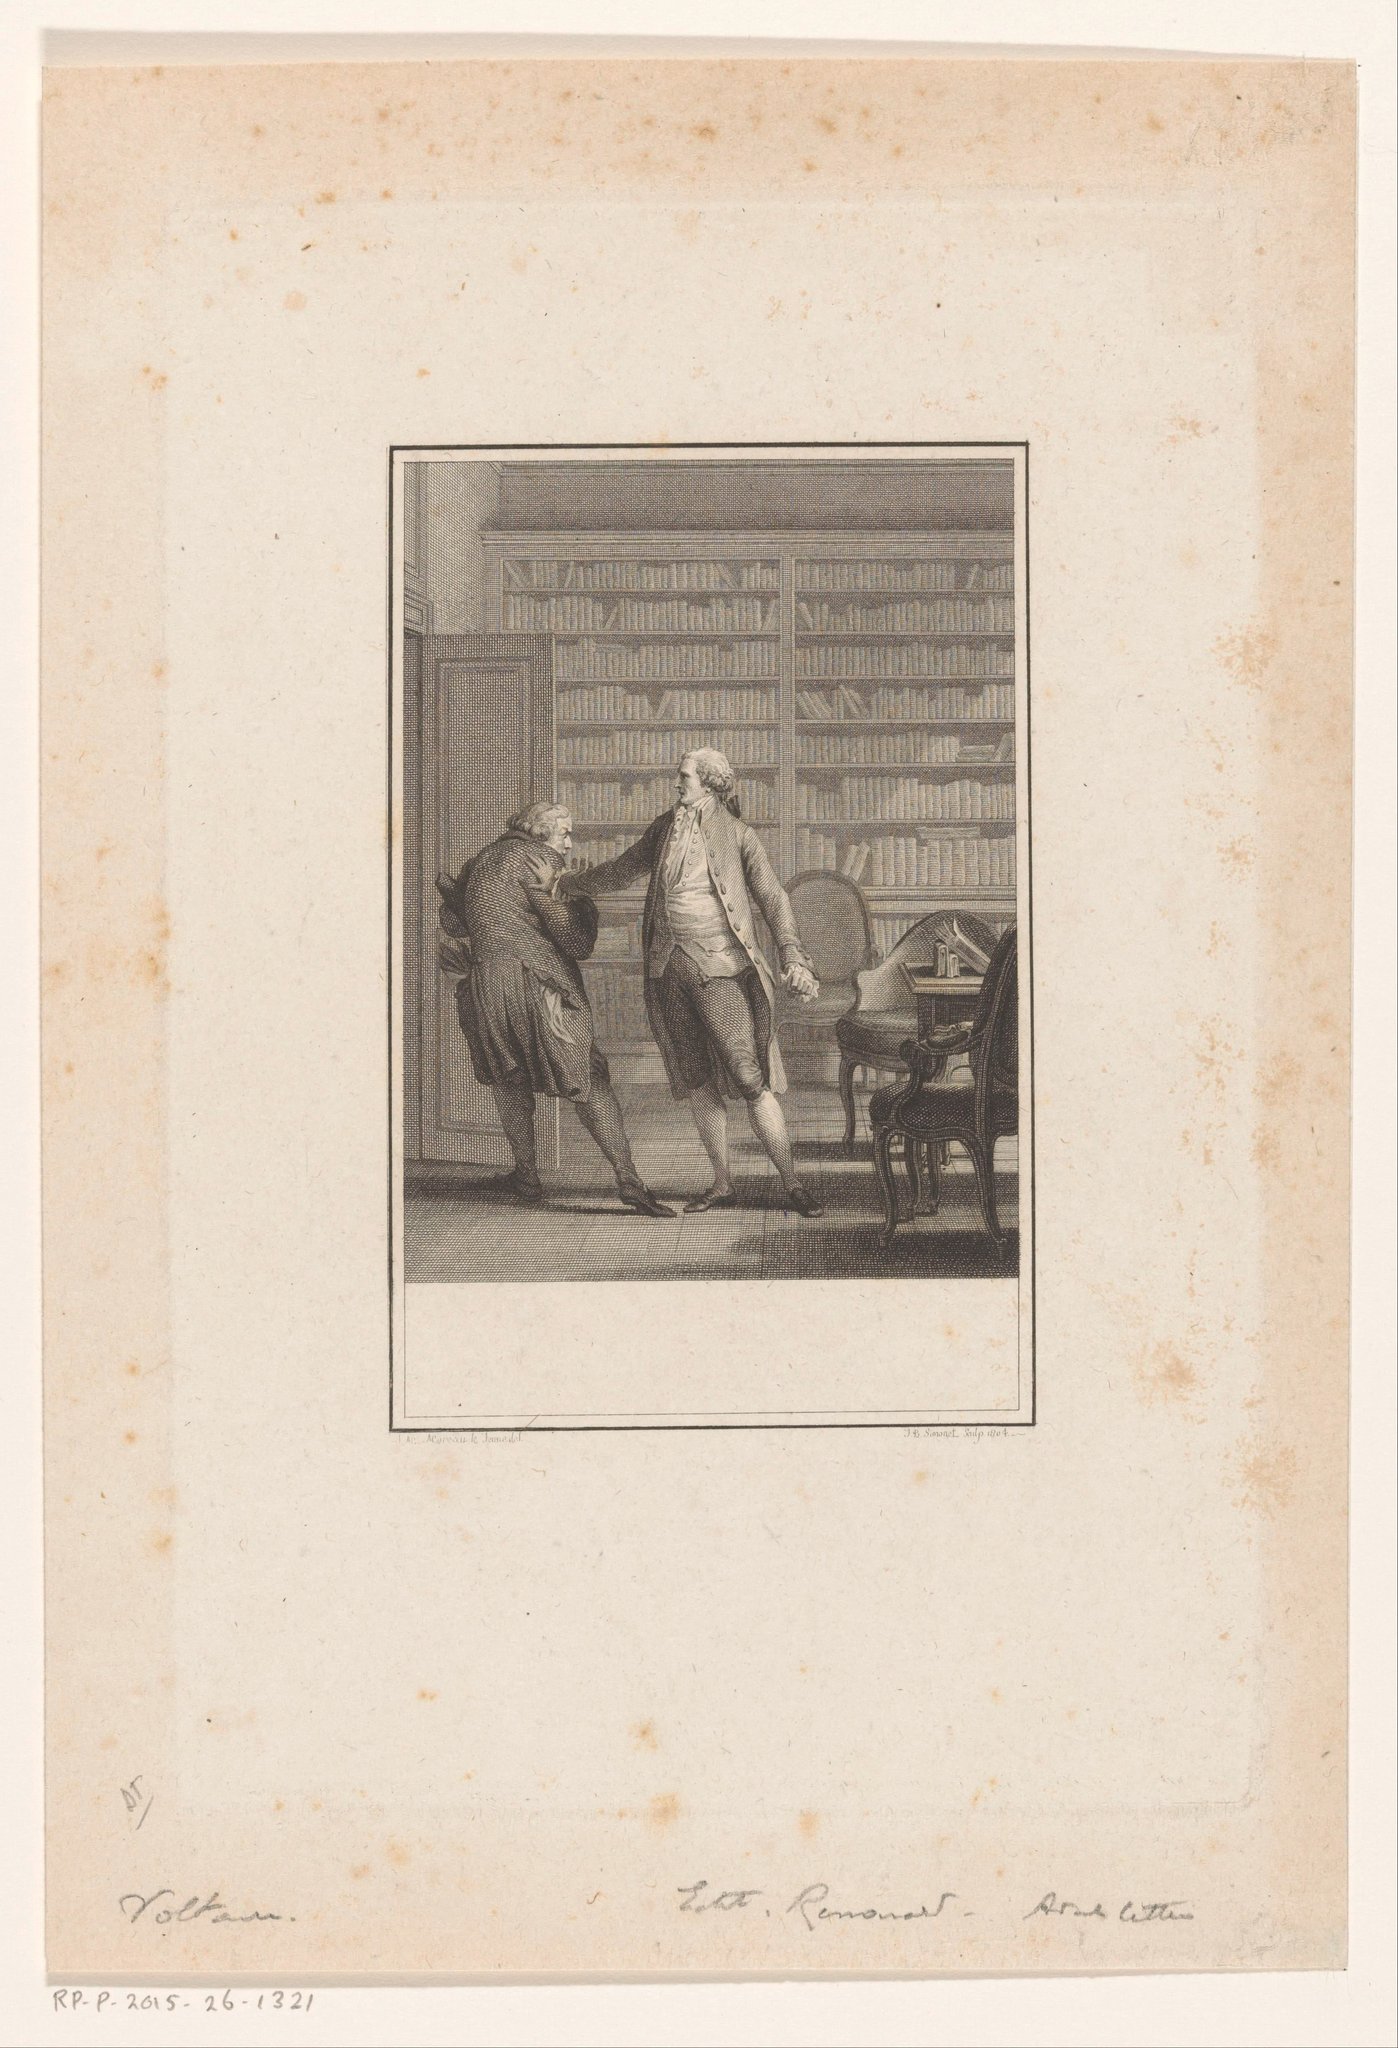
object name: print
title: Twee mannen in een bibliotheek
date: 1804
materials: paper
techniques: engraving, etching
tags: bookshelves, study; 'studiolo'; library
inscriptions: collector's mark: Lugt 2228, collector's mark: Lugt 4779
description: De ene man duwt de andere man richting een openstaande deur. Illustratie van het verhaal 'l'Homme aux 40 écus' door Voltaire.